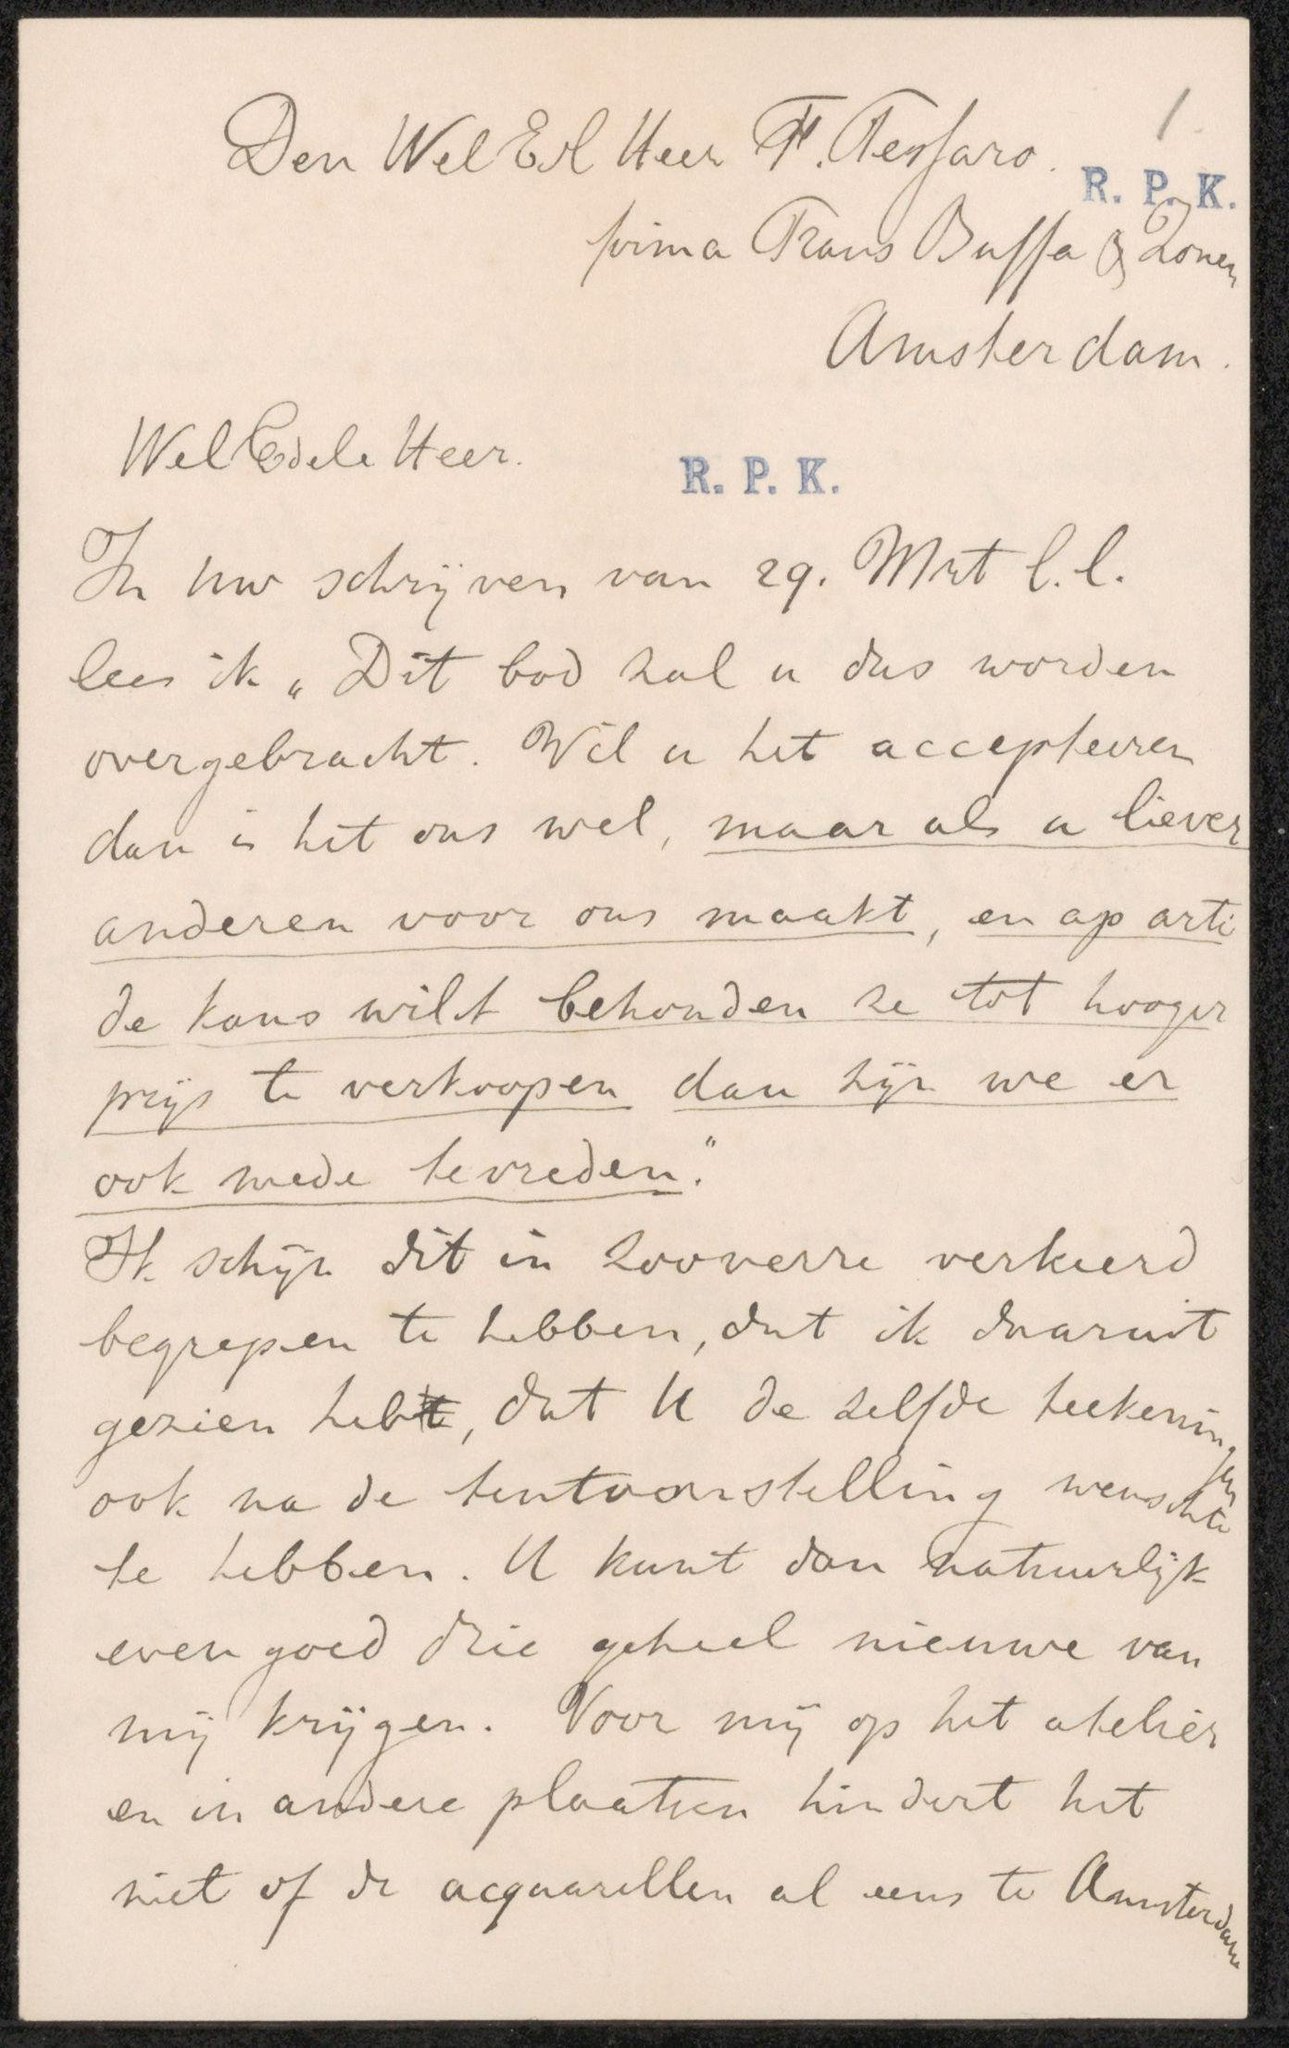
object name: letter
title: Brief aan Filippo Tessaro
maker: menso kamerlingh onnes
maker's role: painter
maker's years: 1860-1925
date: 1891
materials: ink, paper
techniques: pen, writing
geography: leiden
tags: amsterdam, publisher, art trade, art shop, drawing, exhibition ~ art, money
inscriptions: collector's mark: Lugt 2233